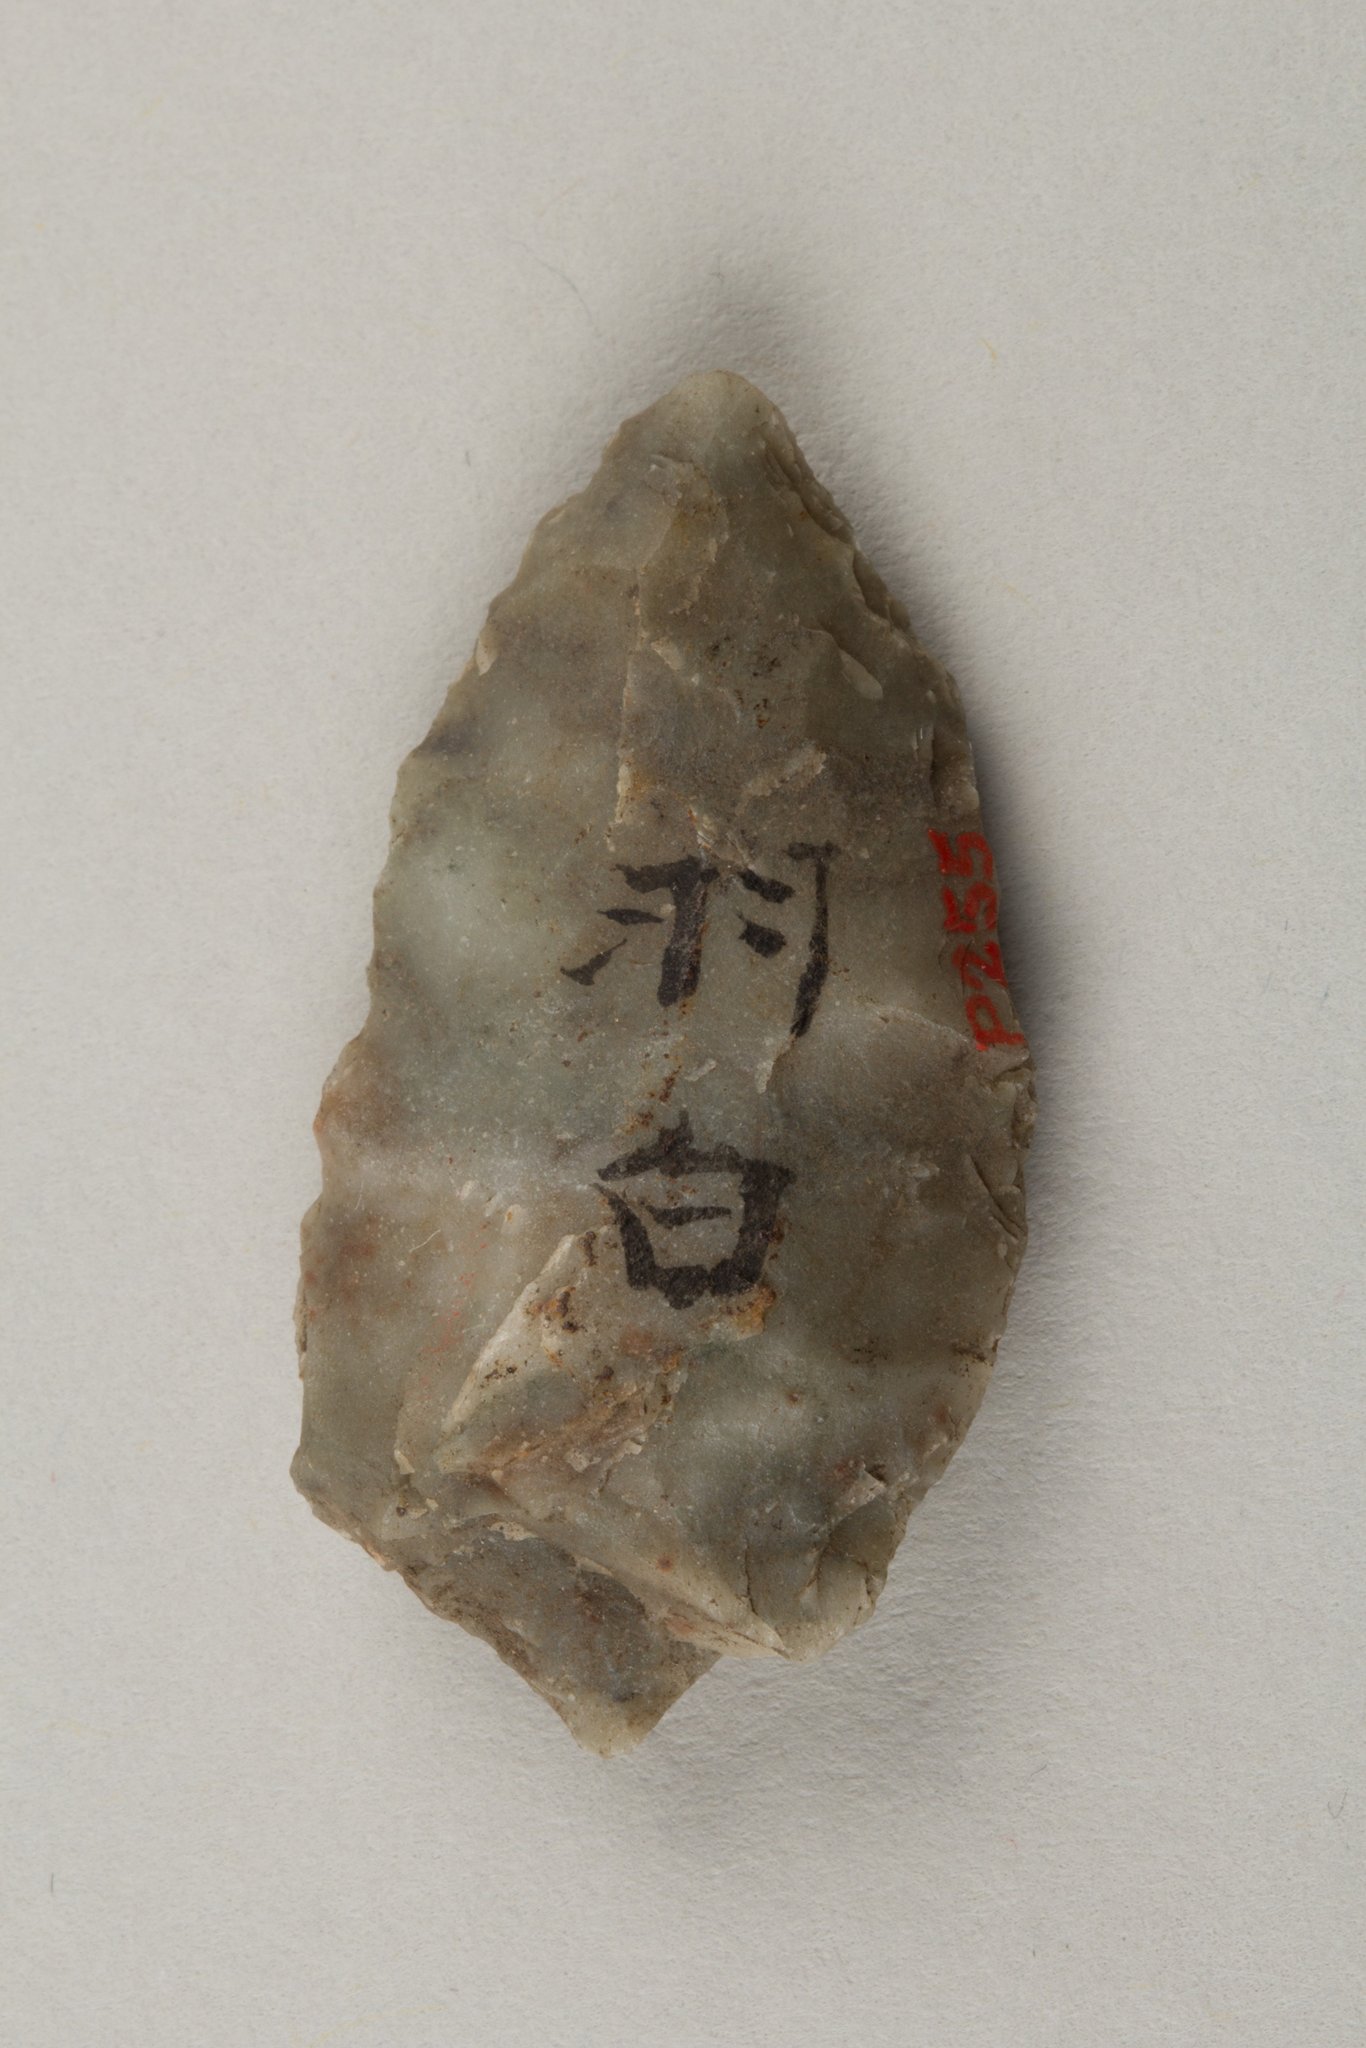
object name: arrowhead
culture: japanese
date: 1500-1000 BCE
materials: stone